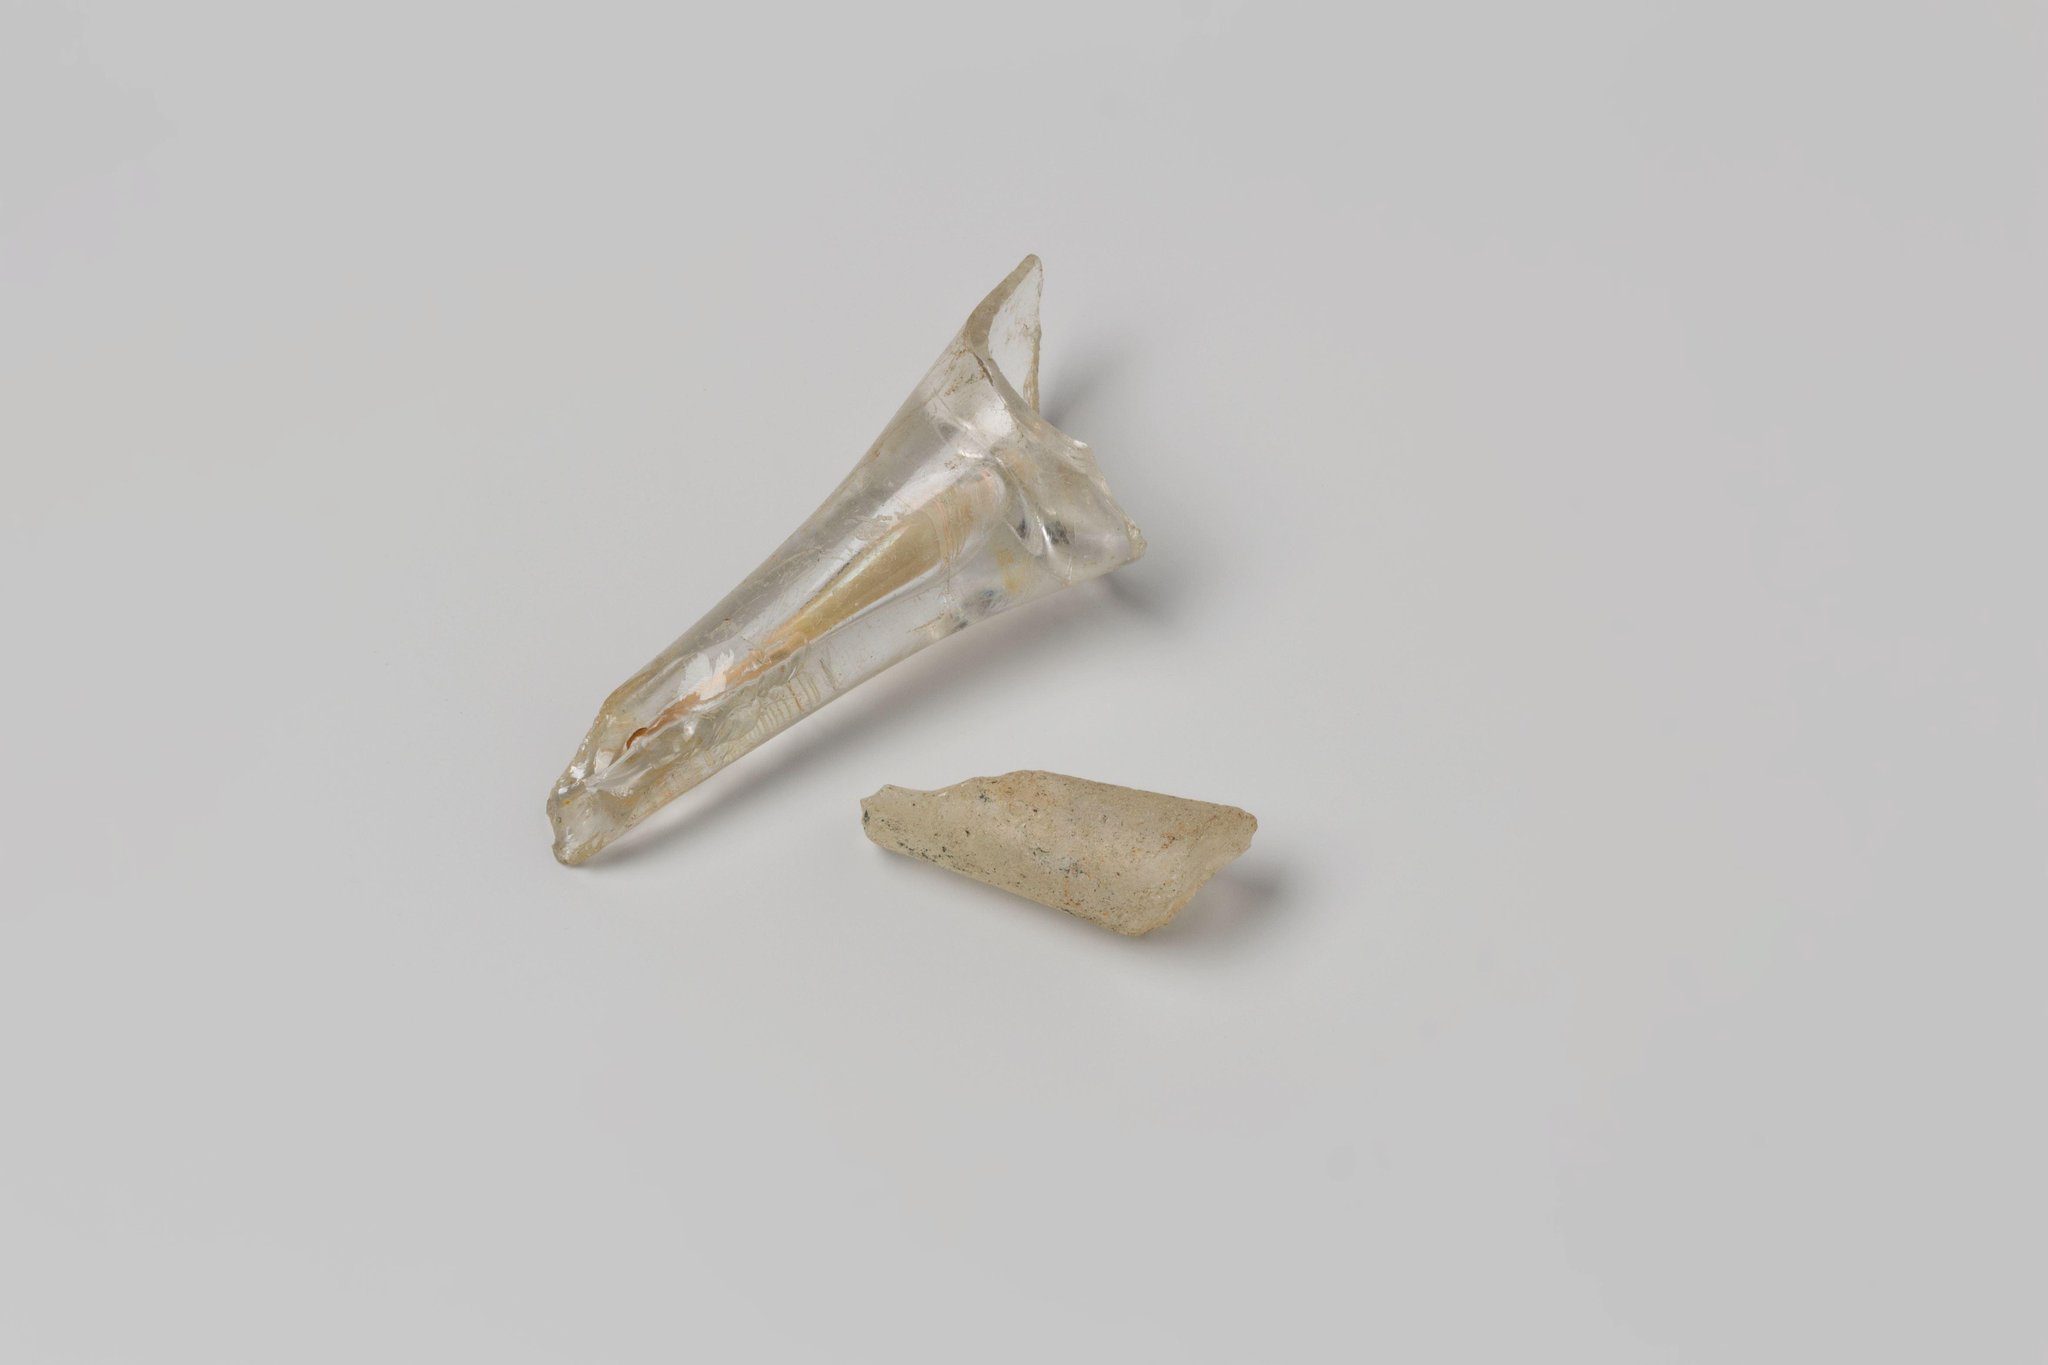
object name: flute glass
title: Fragmenten rechte steel van glas uit het wrak van de Oost-Indiëvaarder Hollandia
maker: Anonymous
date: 1700-1743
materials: glass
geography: netherlands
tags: verenigde oostindische compagnie, hollandia (schip), annet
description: Glass, stem glass, stems, plain; fragm of end with base of bowl, circular, conically everted, hollow core.